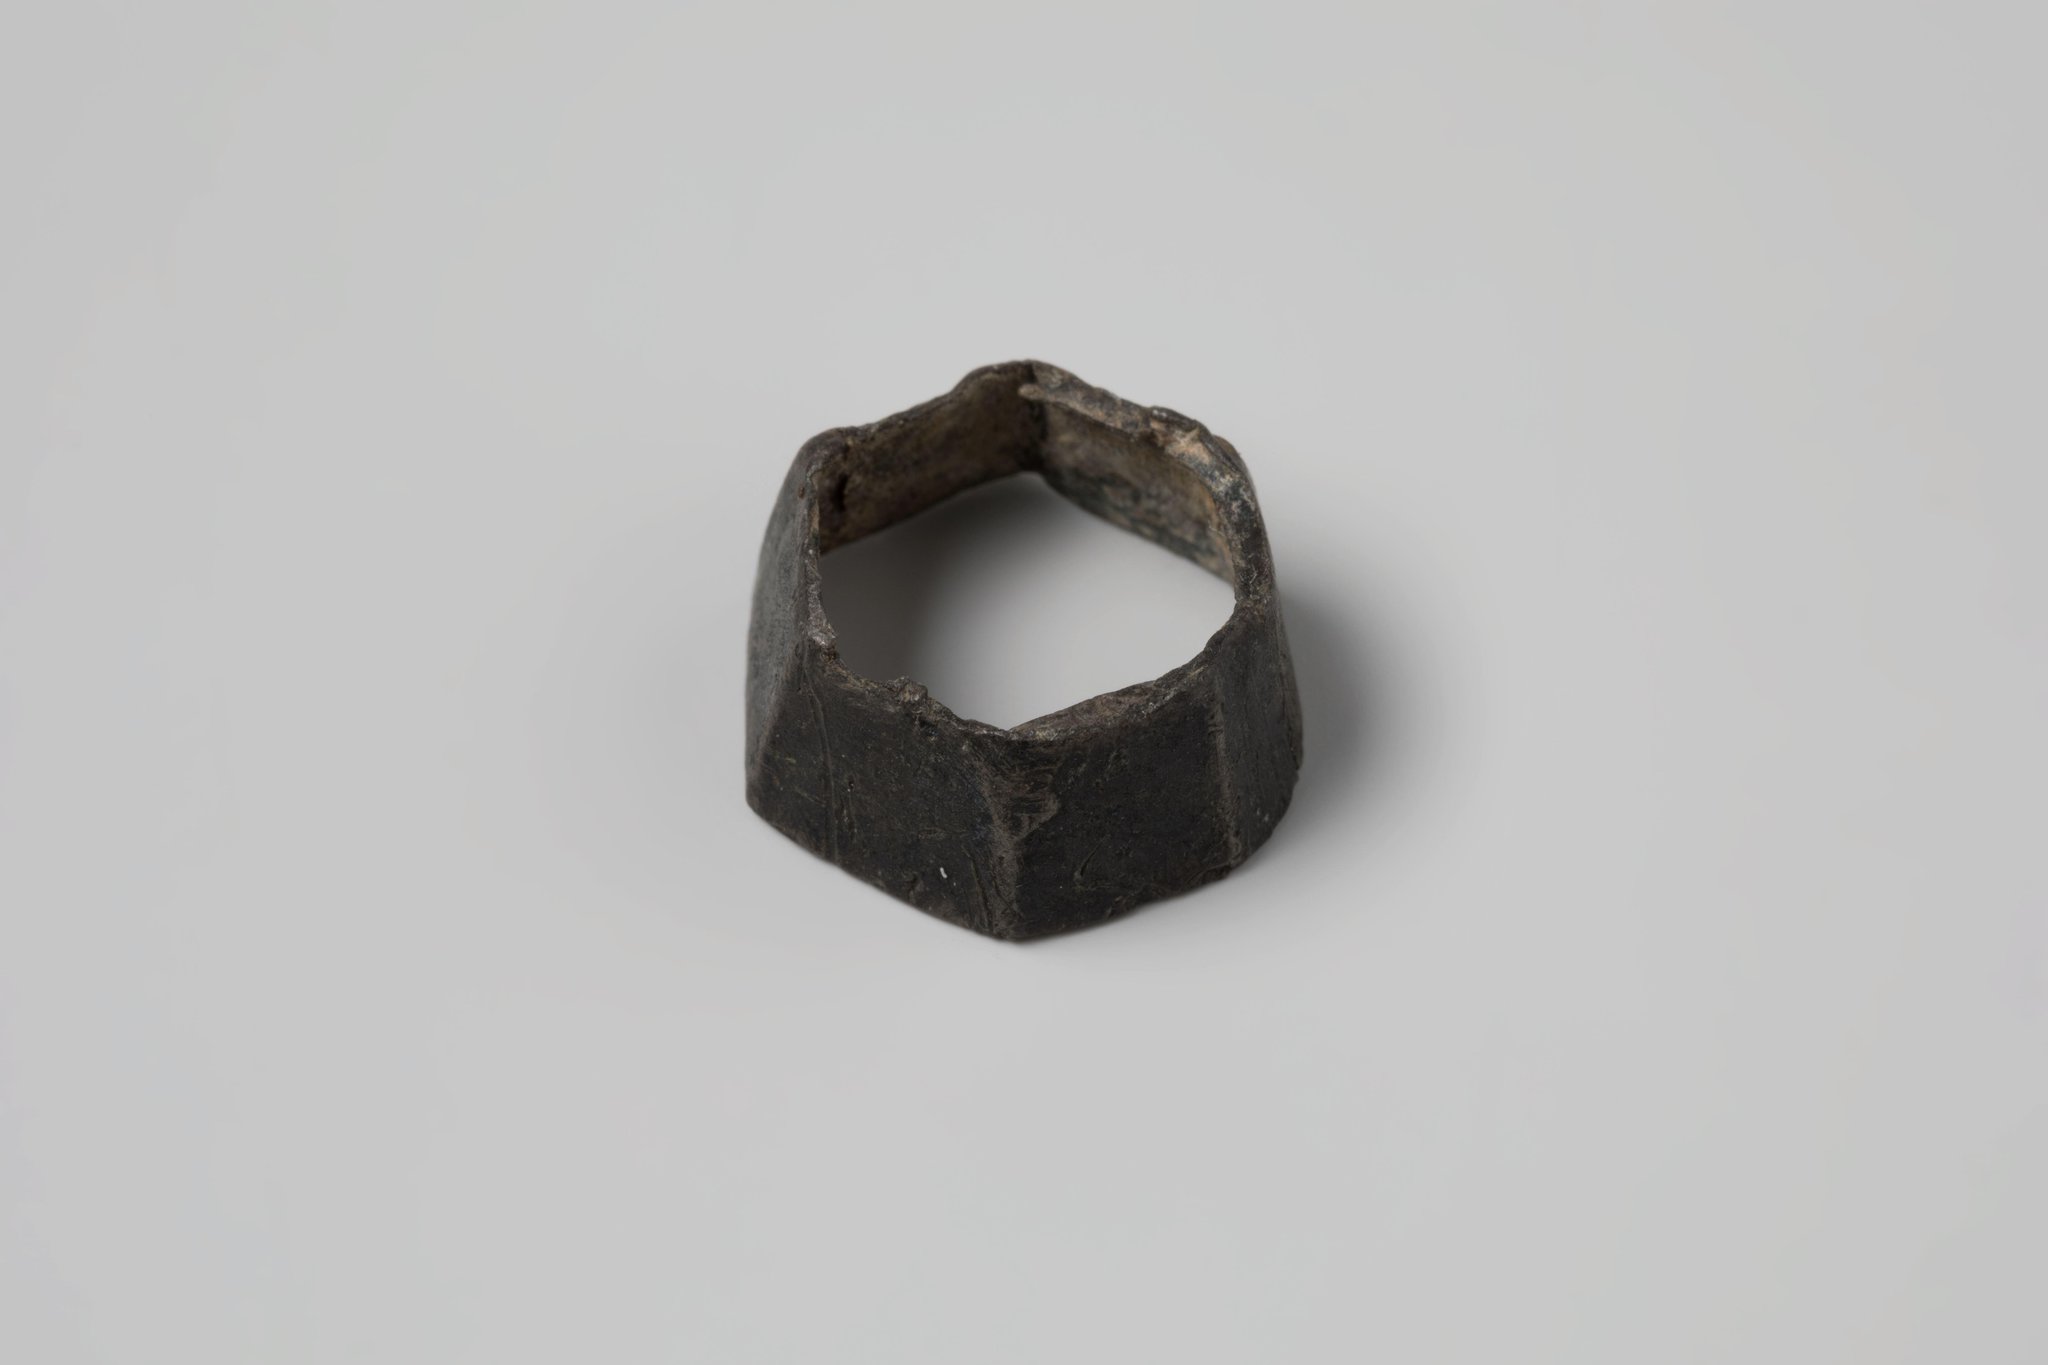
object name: ferrule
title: Messenheftring uit het wrak van de Oost-Indiëvaarder Hollandia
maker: Anonymous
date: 1700-1743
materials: silver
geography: netherlands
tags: verenigde oostindische compagnie, hollandia (schip), annet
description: Knife-handle, ferrule; broad ring, tapering, hexagonal faceted.